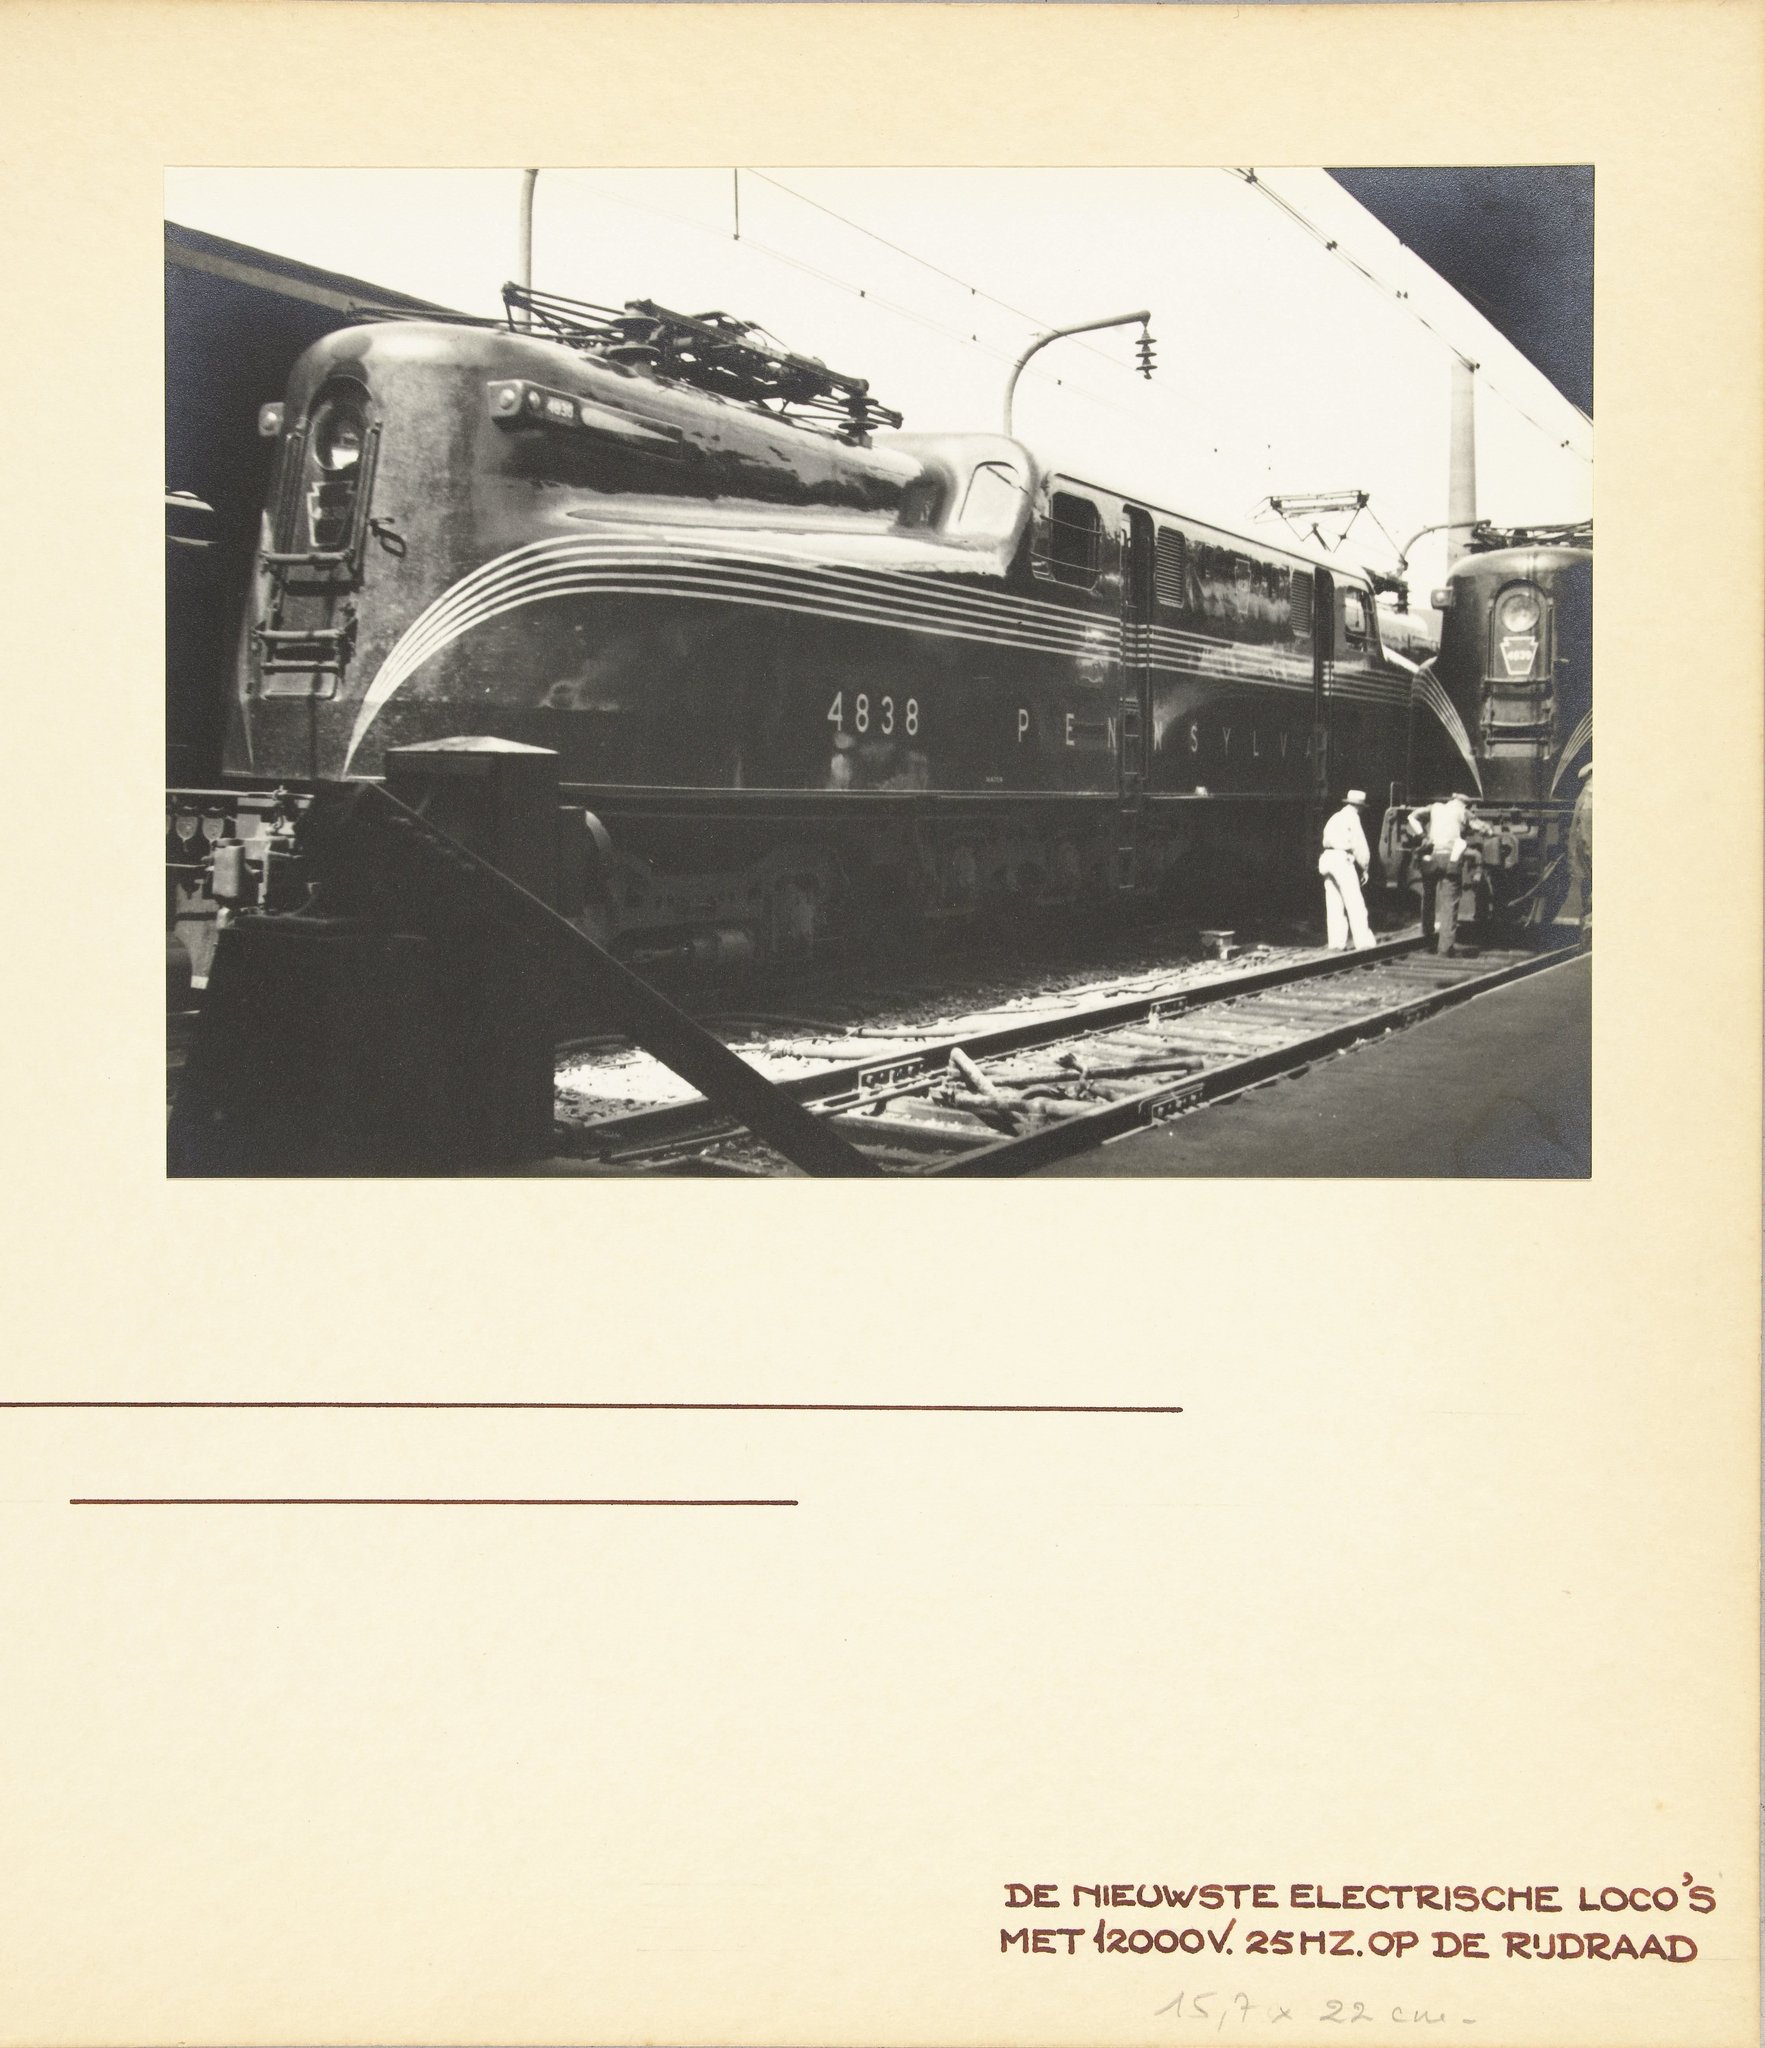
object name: photograph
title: Electrische locomotief op onbekende locatie in de Verenigde Staten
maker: wouter cool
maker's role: engineer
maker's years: 1877-1947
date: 1936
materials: cardboard, paper, photographic support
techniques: gelatin silver print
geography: united states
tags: electric locomotive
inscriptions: title: ‘DE NIEUWSTE ELECTRISCHE LOCO'S / MET 12000V. 25HZ. OP DE RIJDRAAD’